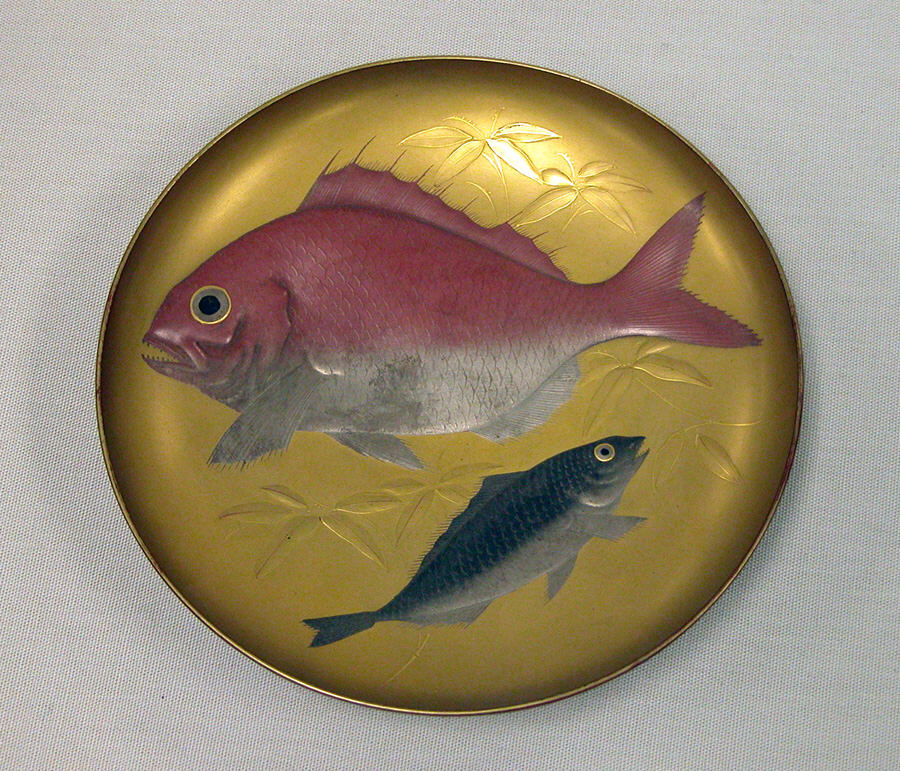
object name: wine cup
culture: japanese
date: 1801-1900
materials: gold, lacquer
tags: fish